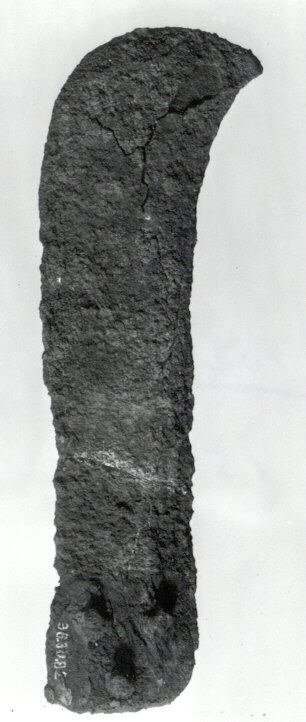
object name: knife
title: Knife blade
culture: sasanian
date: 201-700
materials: iron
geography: iran